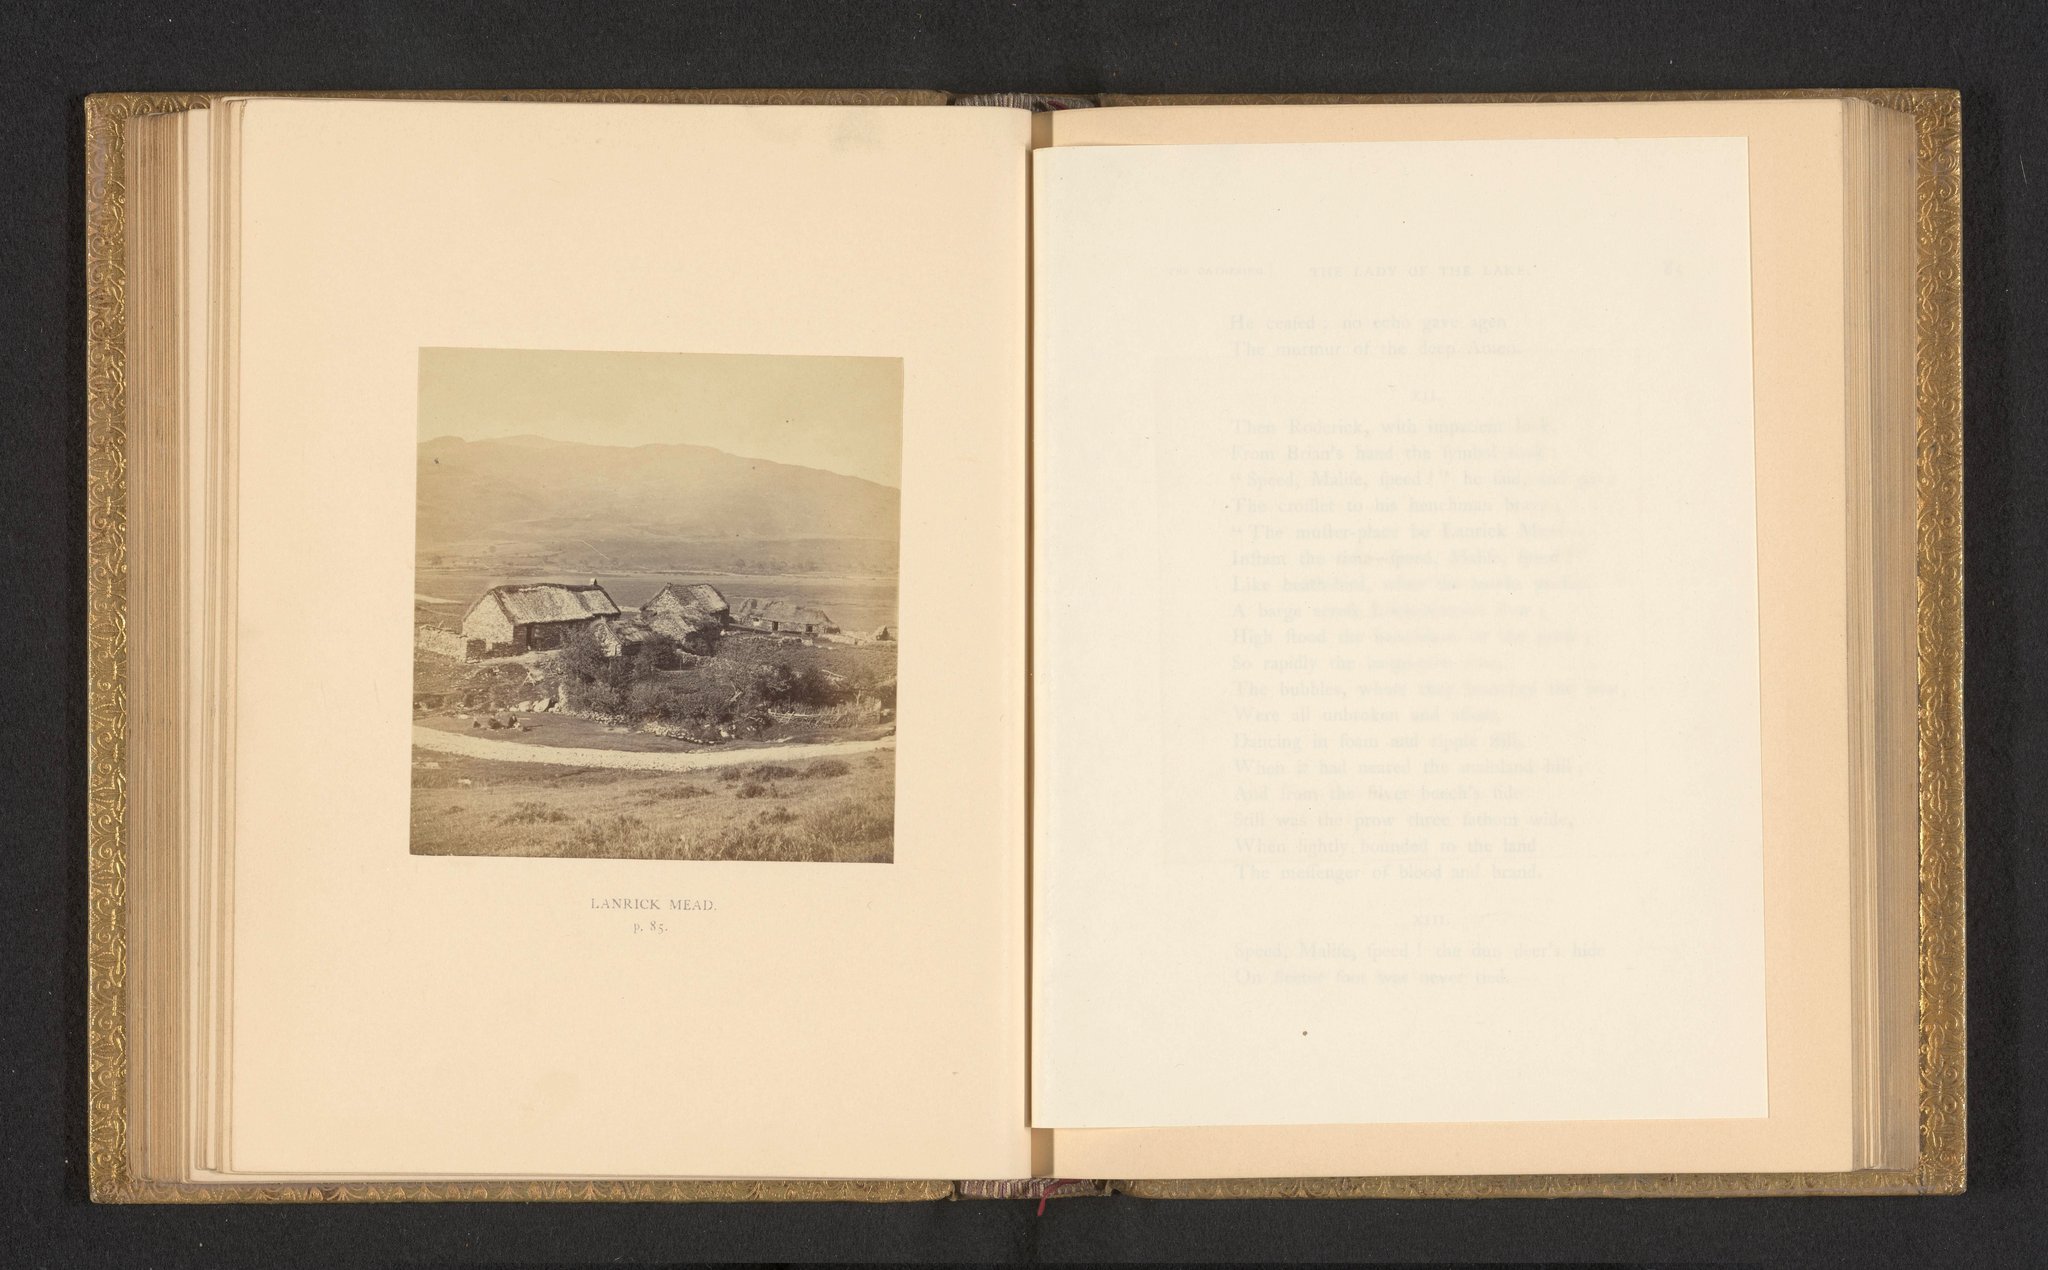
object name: photograph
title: Lanrick Mead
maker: thomas ogle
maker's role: fotograaf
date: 1853-1865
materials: photographic support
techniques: albumen print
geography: scotland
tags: dale, valley, farm (building)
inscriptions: number: ‘P. 85.’